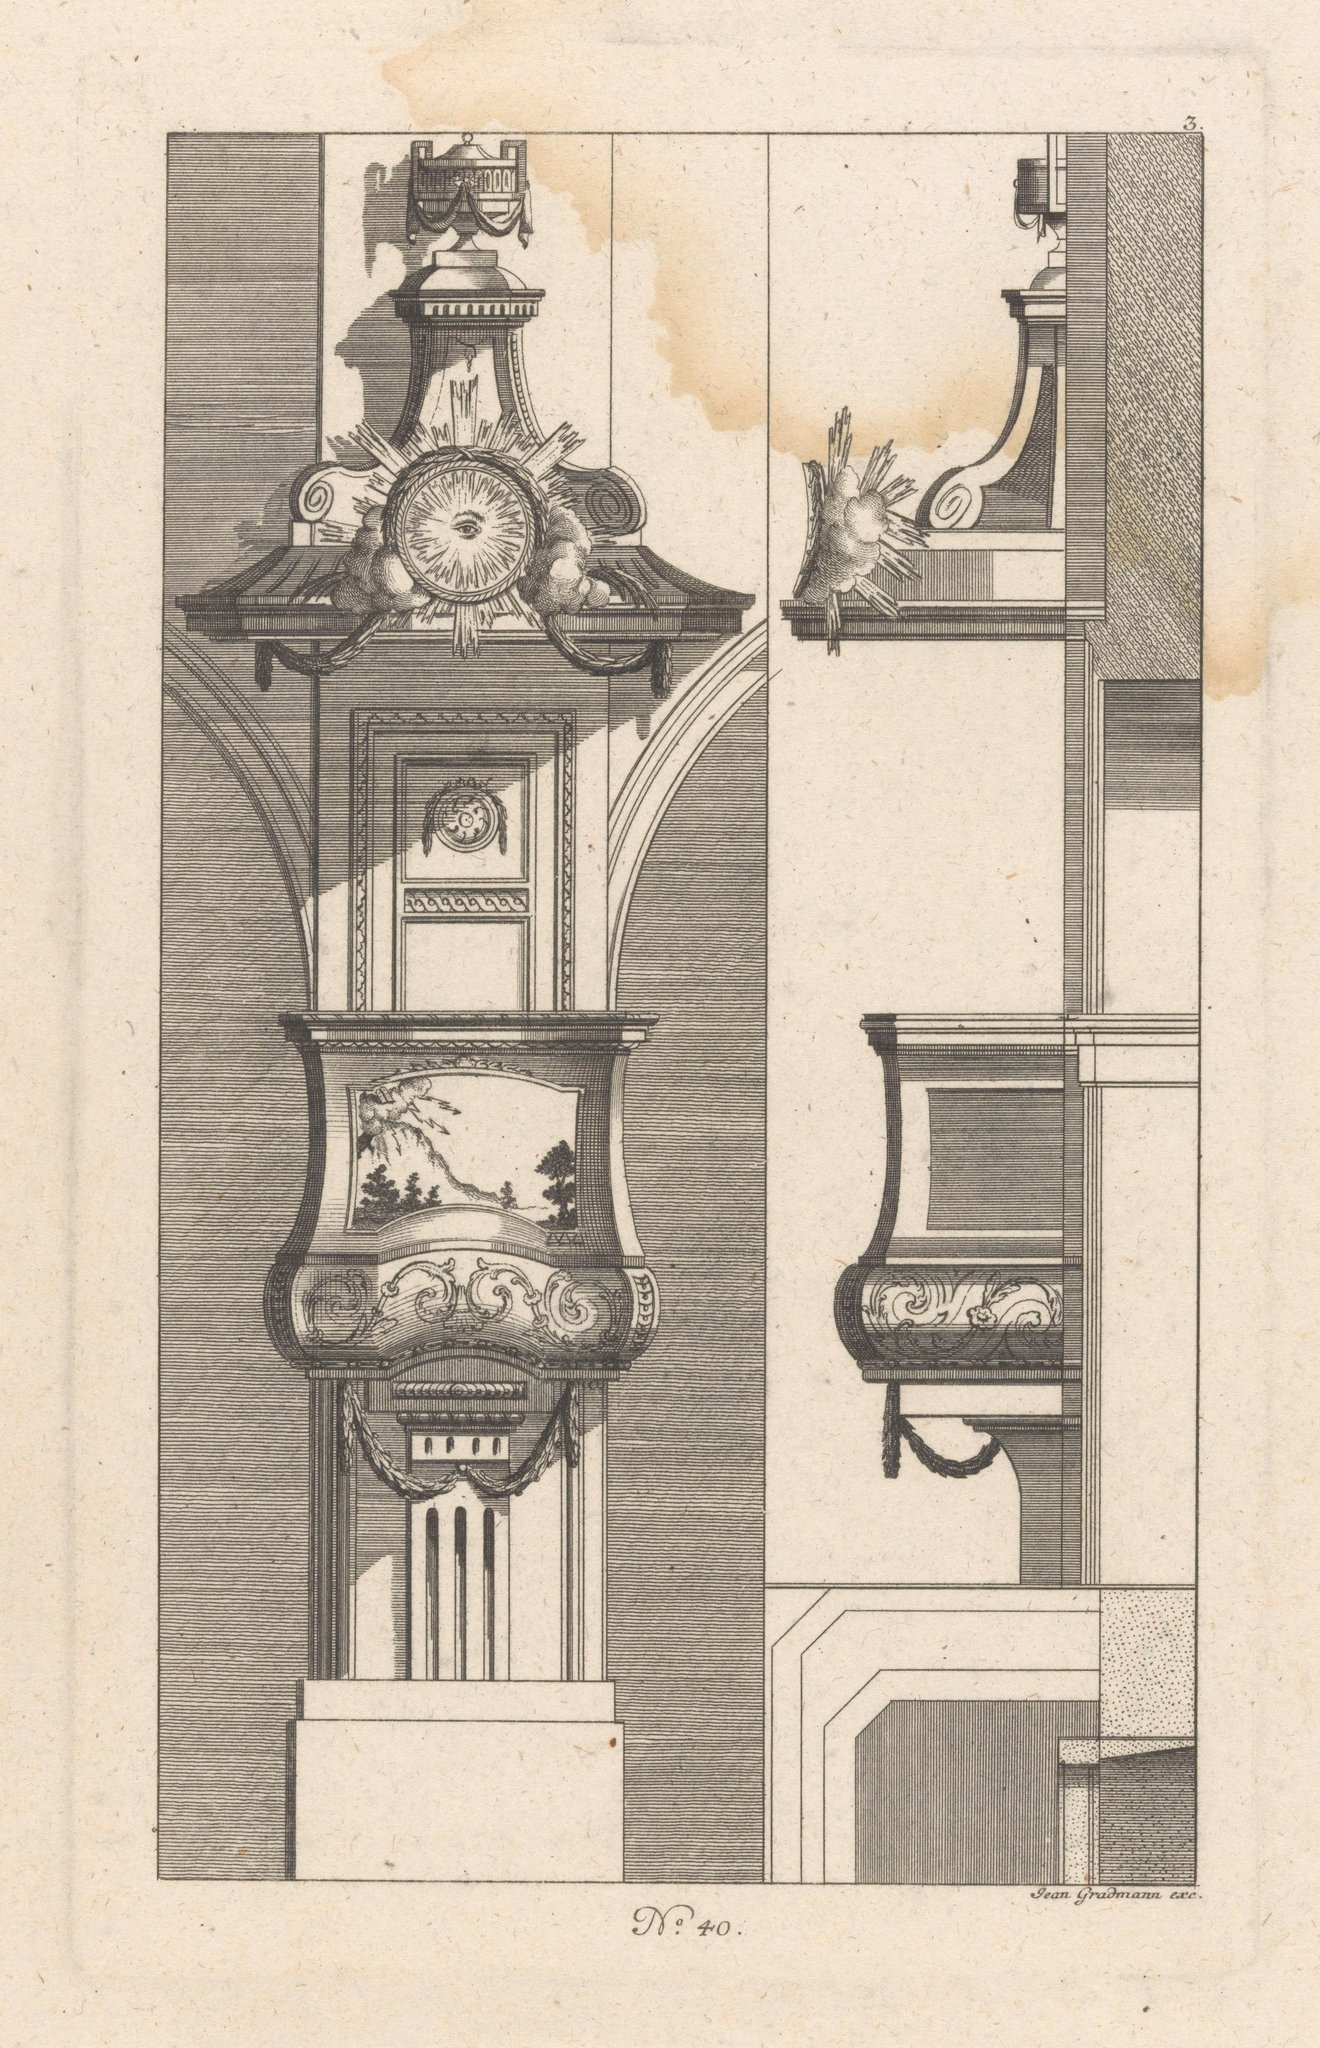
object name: print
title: Kerkelijke meubels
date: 1780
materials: paper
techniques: engraving, etching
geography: ravensburg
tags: pulpit, ambo, chancel, the all-seeing eye, triangle with eye ~ symbol of god the father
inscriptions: collector's mark: Lugt 2760, collector's mark: Lugt 2228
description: Ontwerp, zijaanzicht en plattegrond van een geornamenteerde preekstoel. Op de kuip een afbeelding van een landschap, op de bekroning het alzien oog omgeven door wolken, stralen en guirlandes met daarboven een vaas. Uitgeversnummer 40.